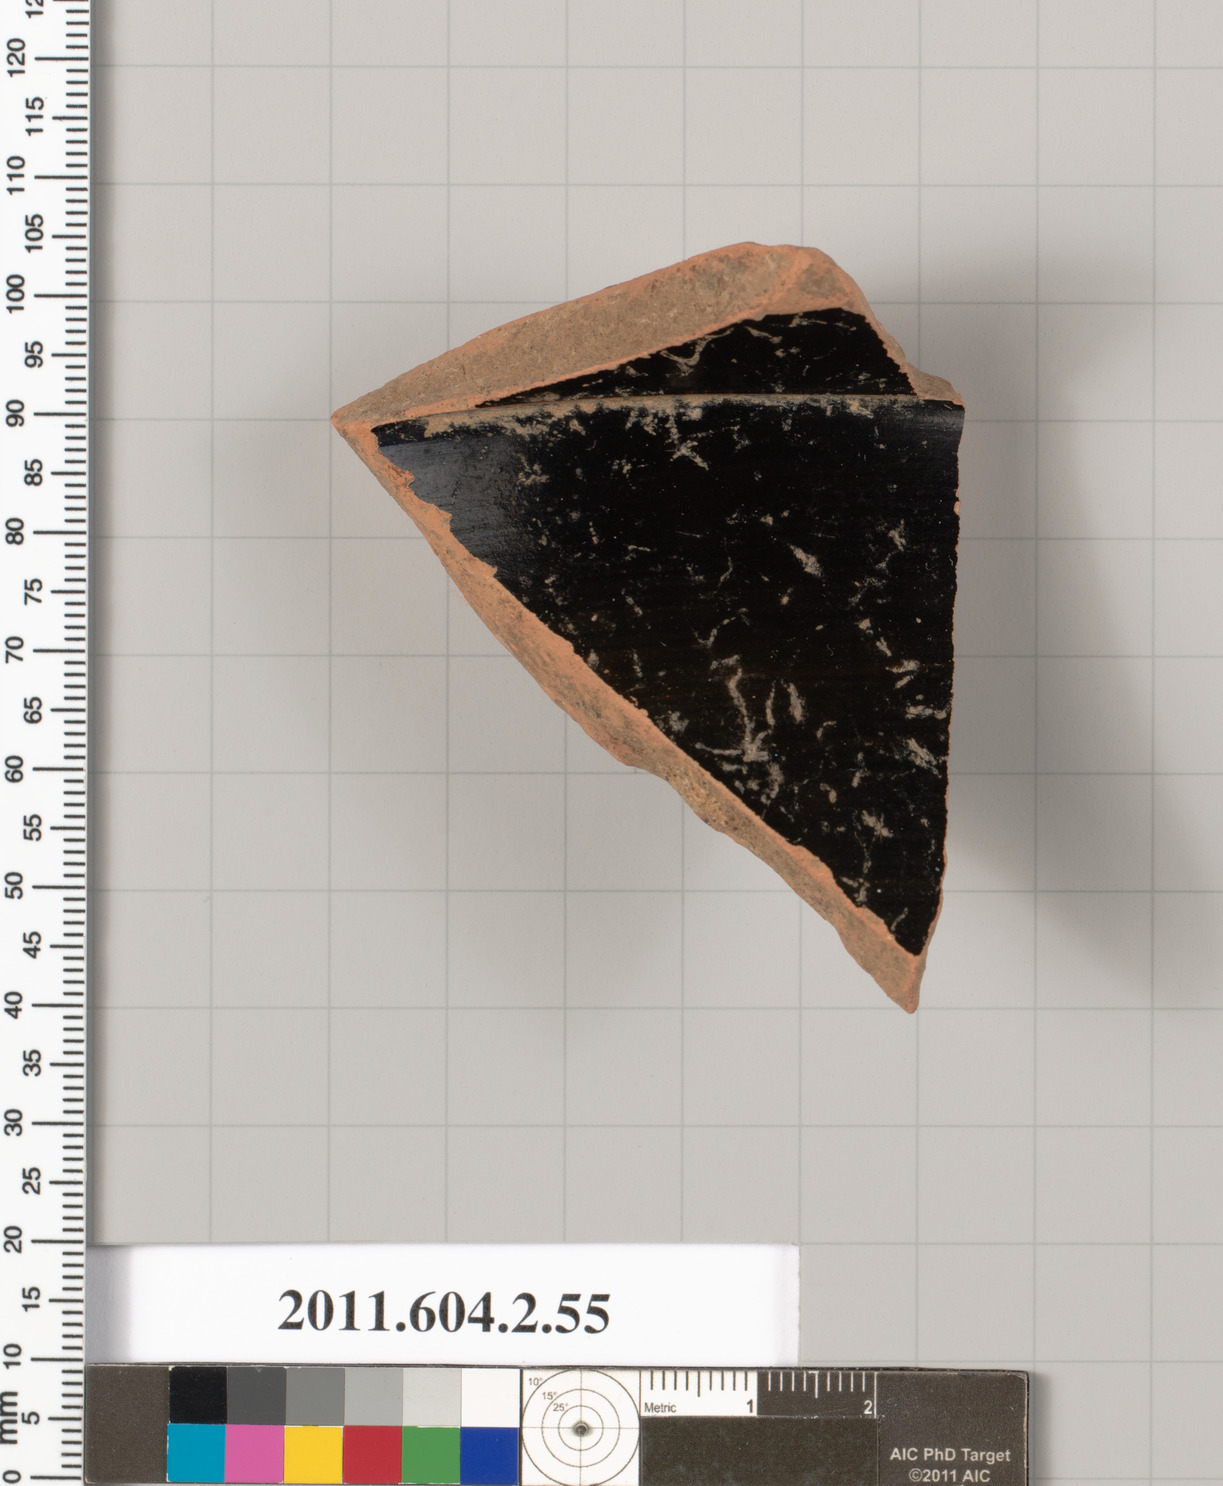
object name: pot fragment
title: Terracotta fragment of a pot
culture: greek, attic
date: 534-468 BCE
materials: terracotta